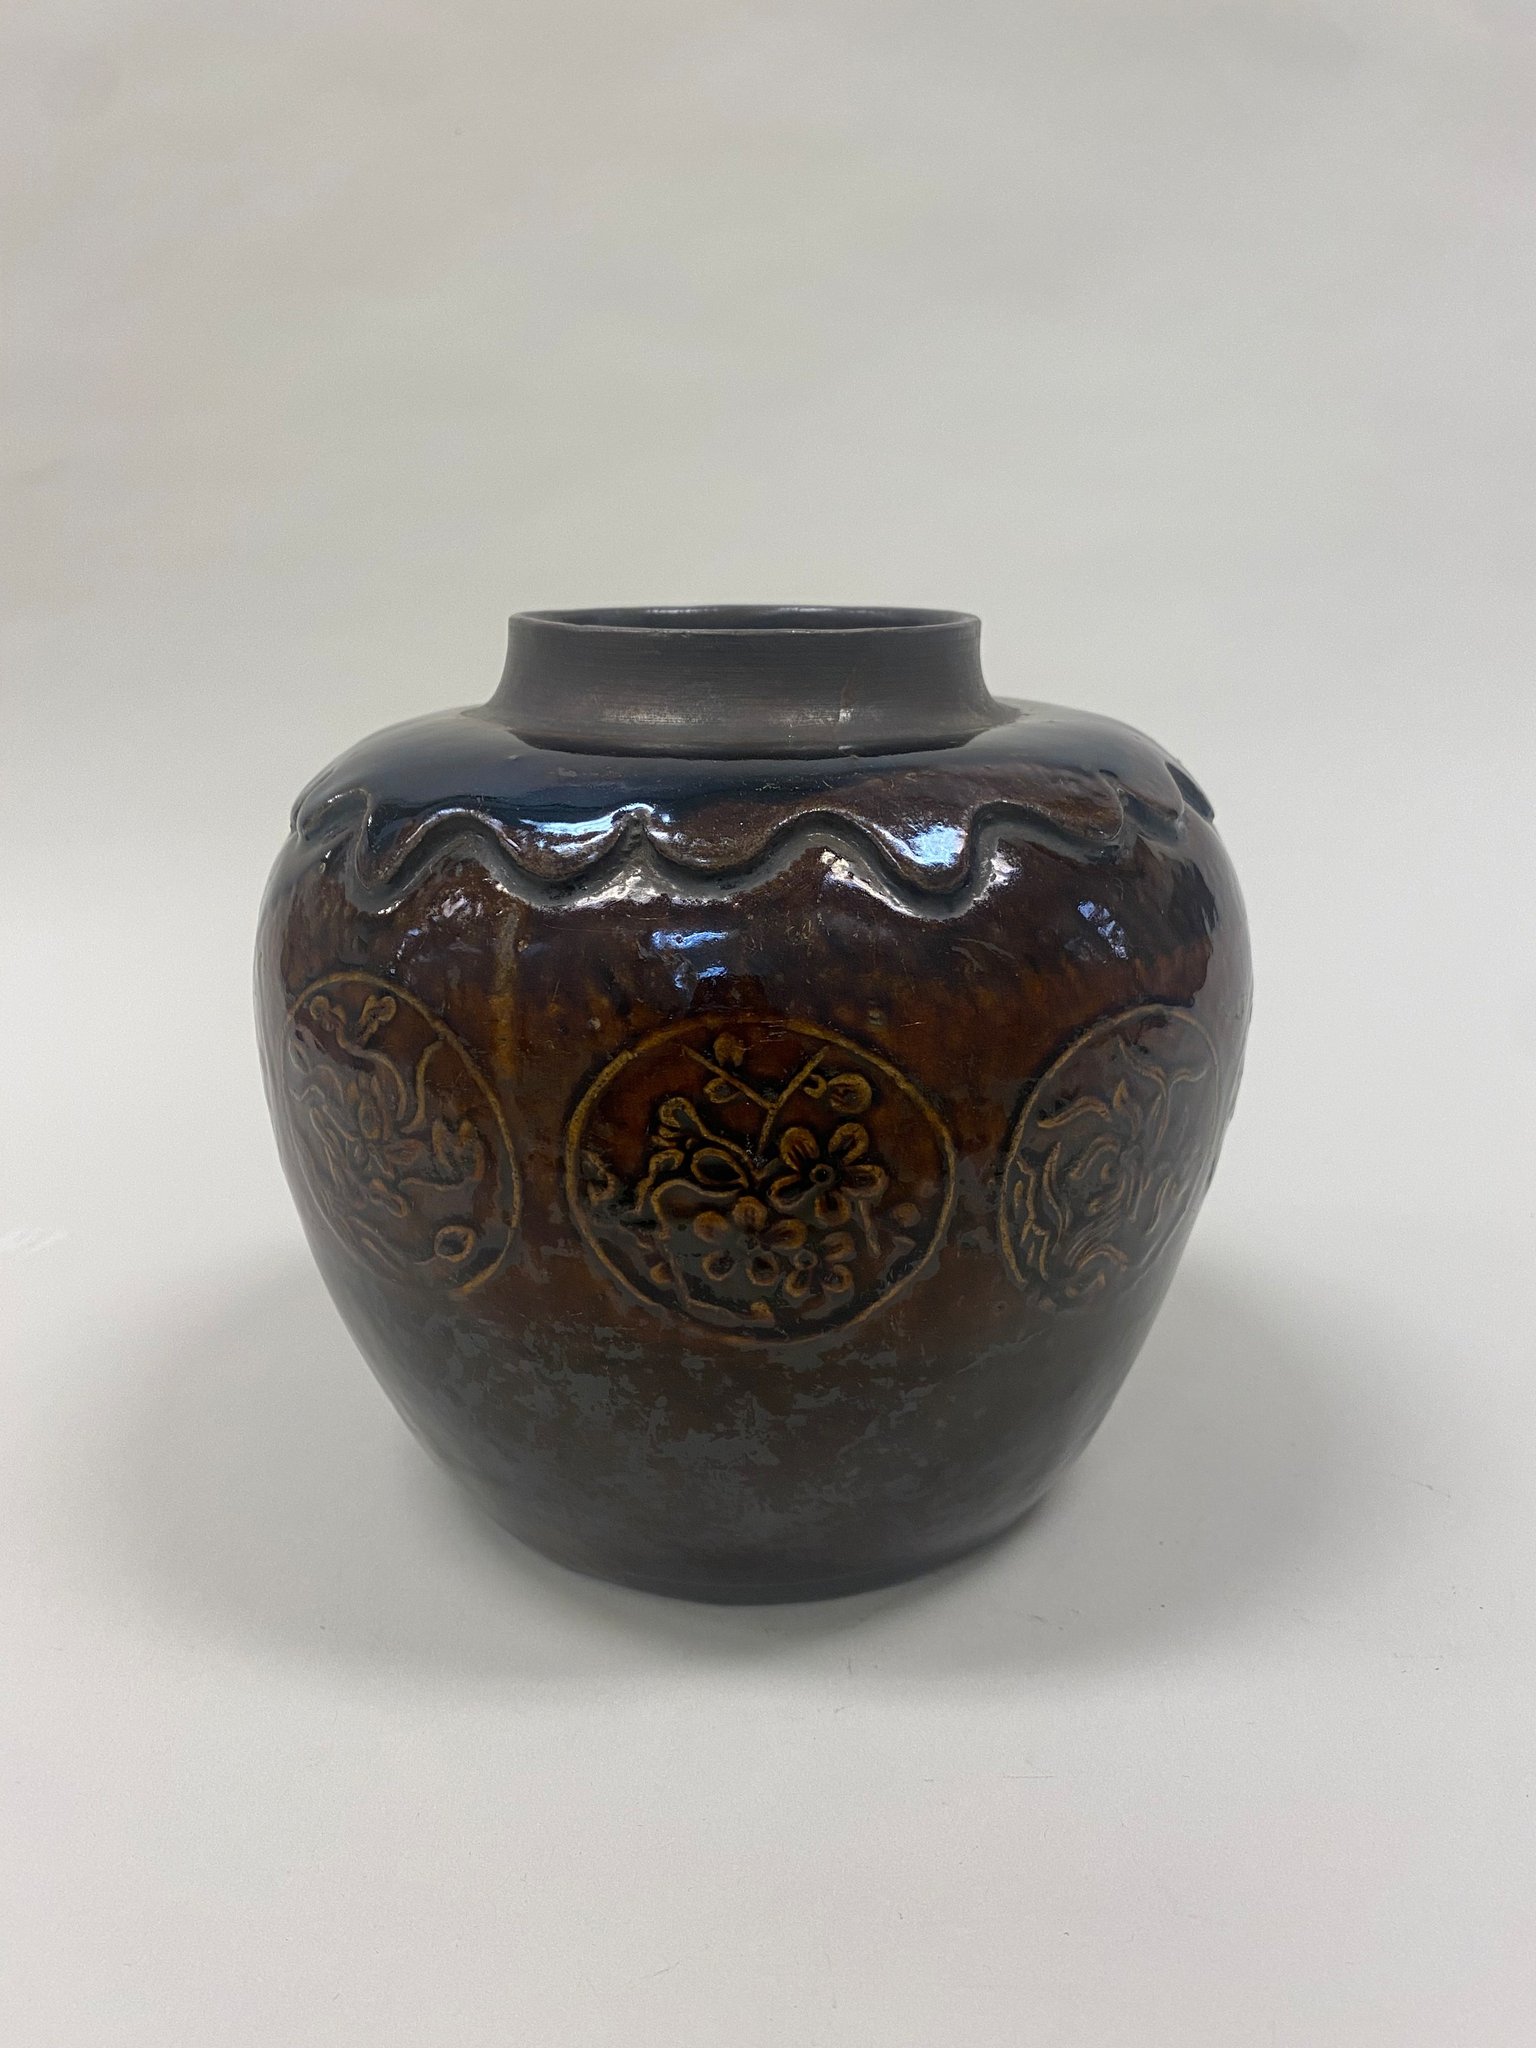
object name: jar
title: Jar with floral medallions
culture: chinese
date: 1801-1900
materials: glaze, stoneware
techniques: relief